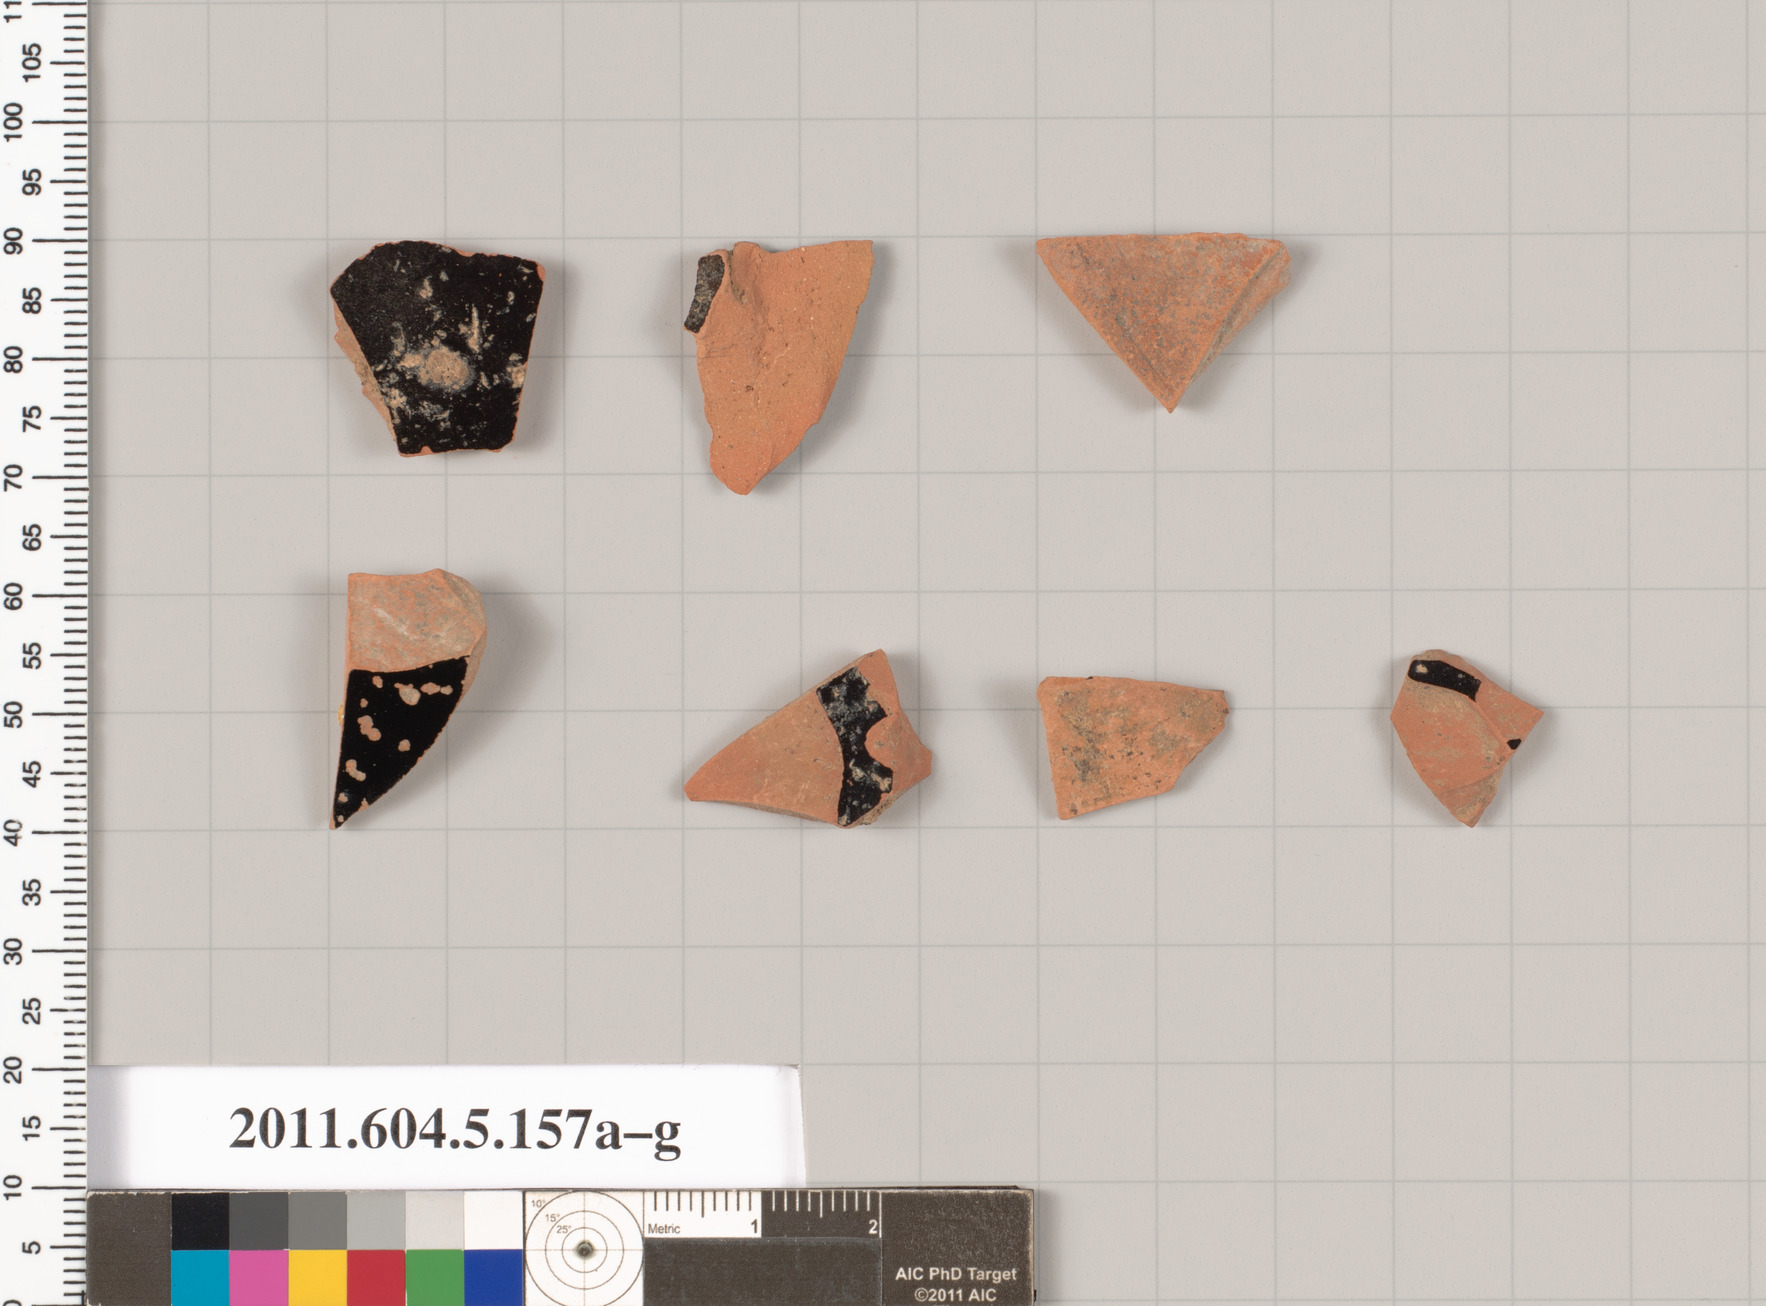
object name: kylix fragment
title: Terracotta fragments of kylikes (drinking cups)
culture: greek, attic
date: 600-401 BCE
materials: terracotta